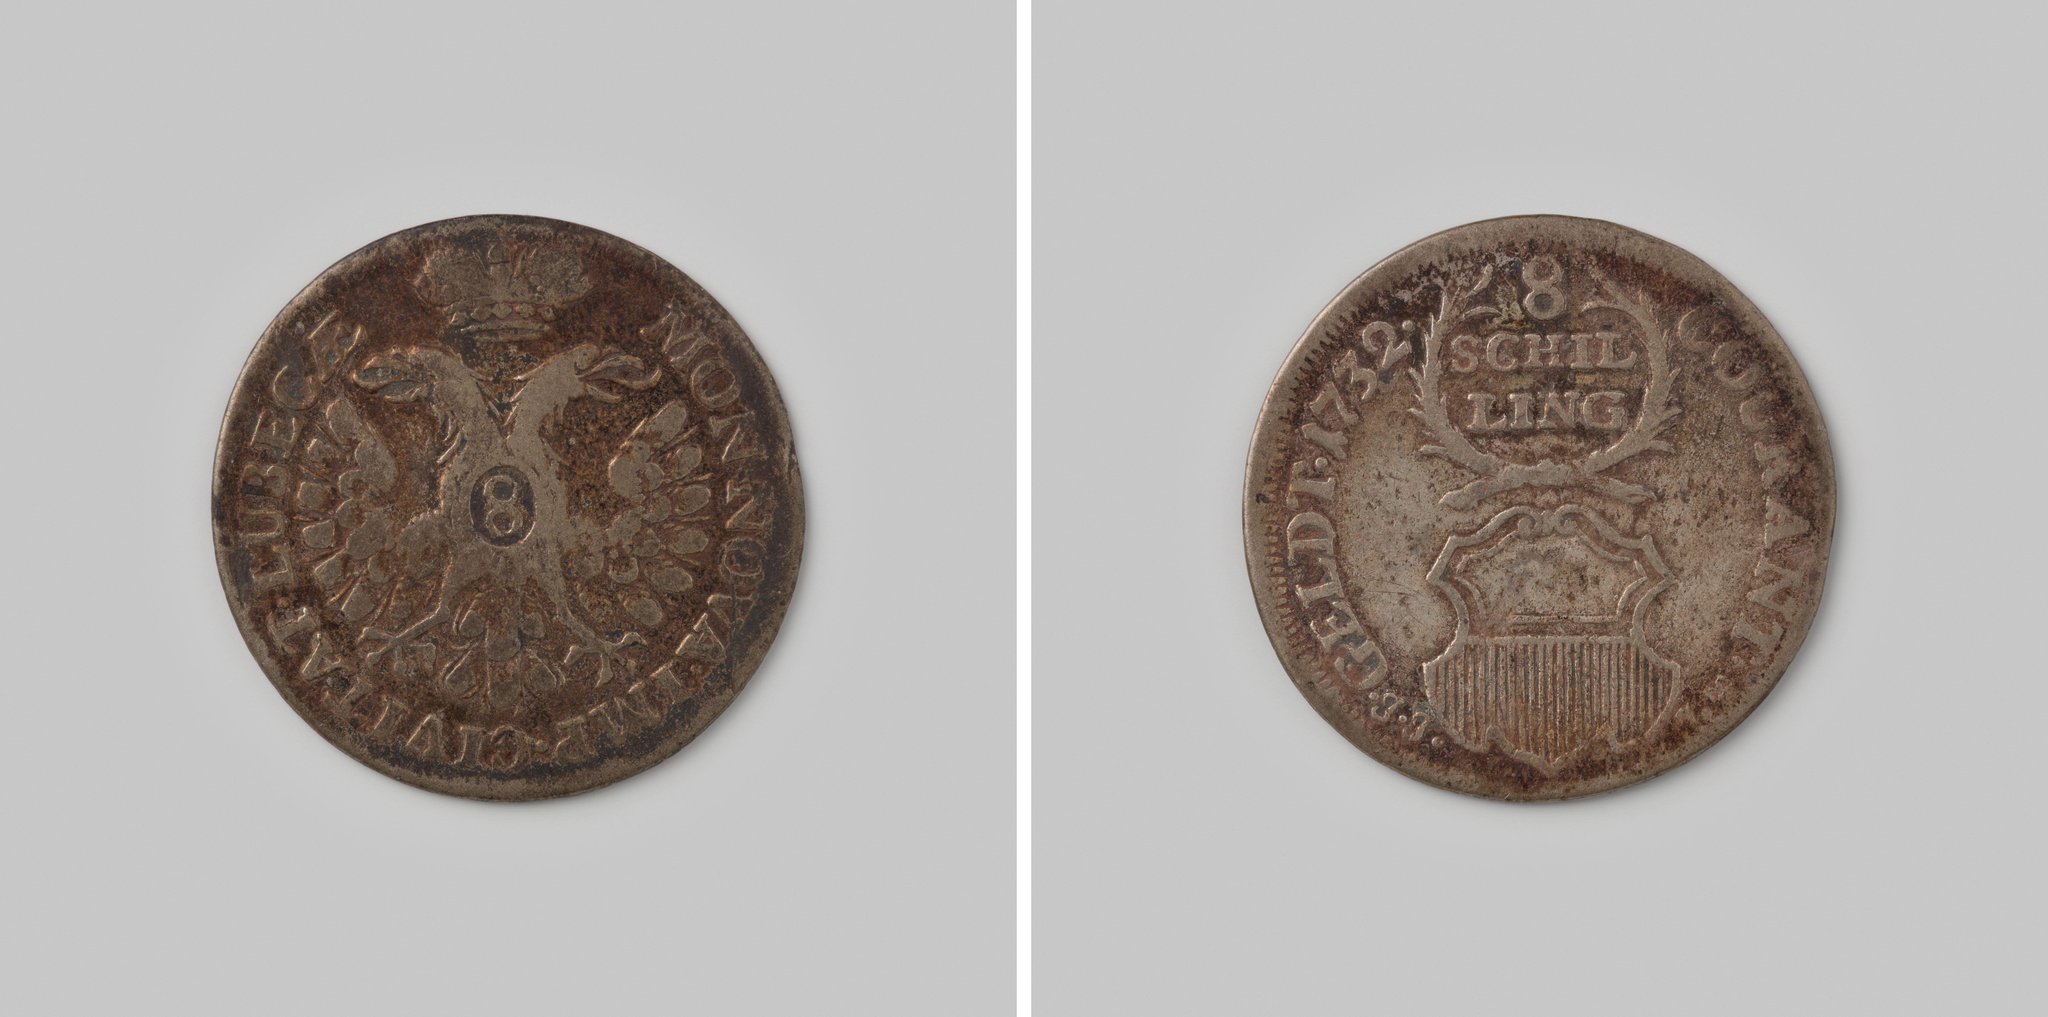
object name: coin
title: 8 Schilling uit de vrije hansestad Lübeck, 1732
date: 1732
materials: silver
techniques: striking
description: Zilveren munt. Voorzijde: gekroonde dubbelkoppige adelaar met op de borst het cijfer 8. Keerzijde: binnen twee samengebonden takken waarde-aanduiding in drie regels, waaronder wapenschild van de stad. Jaartal bovenaan aan eind van omschrift. Gladde rand.